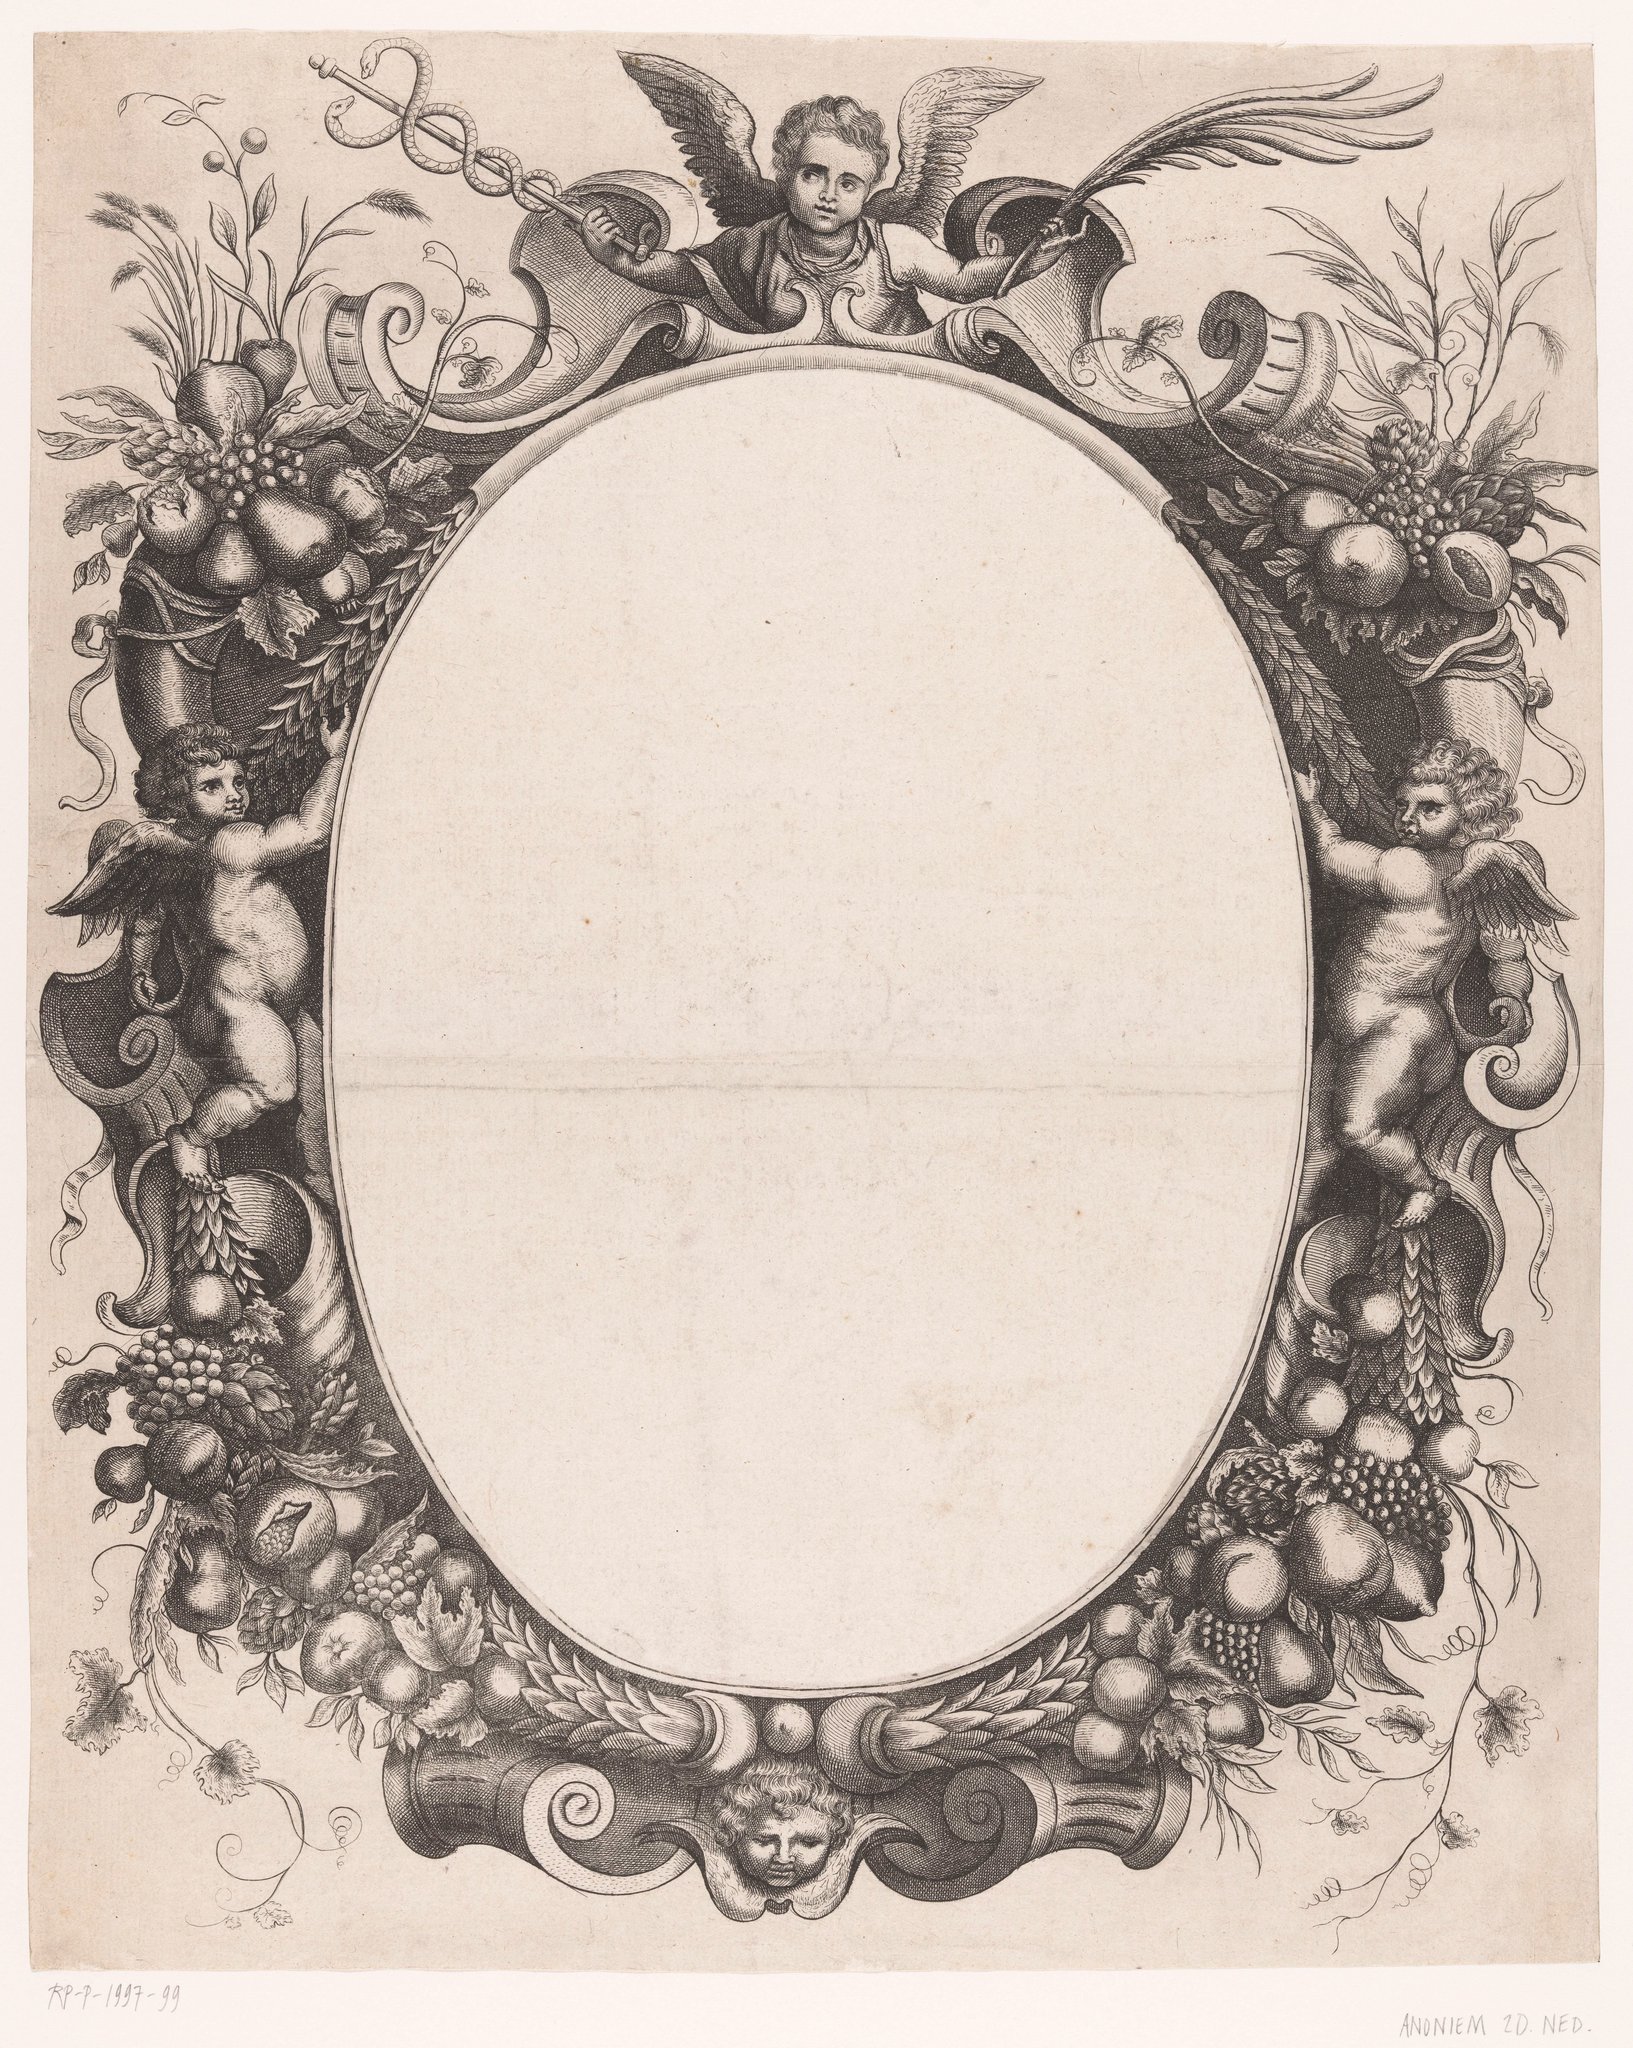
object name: print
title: Omlijsting met putti en vruchten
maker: Anonymous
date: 1670-1680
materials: paper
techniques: engraving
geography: southern netherlands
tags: fruits and vegetables ~ ornament, ornaments ~ art (+ framing decorations), cupids: 'amores', 'amoretti', 'putti'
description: Ornamentale ovale omlijsting met putti, voluten en vruchten. Midden boven een putto met Mercuriusstaf en palmtak.